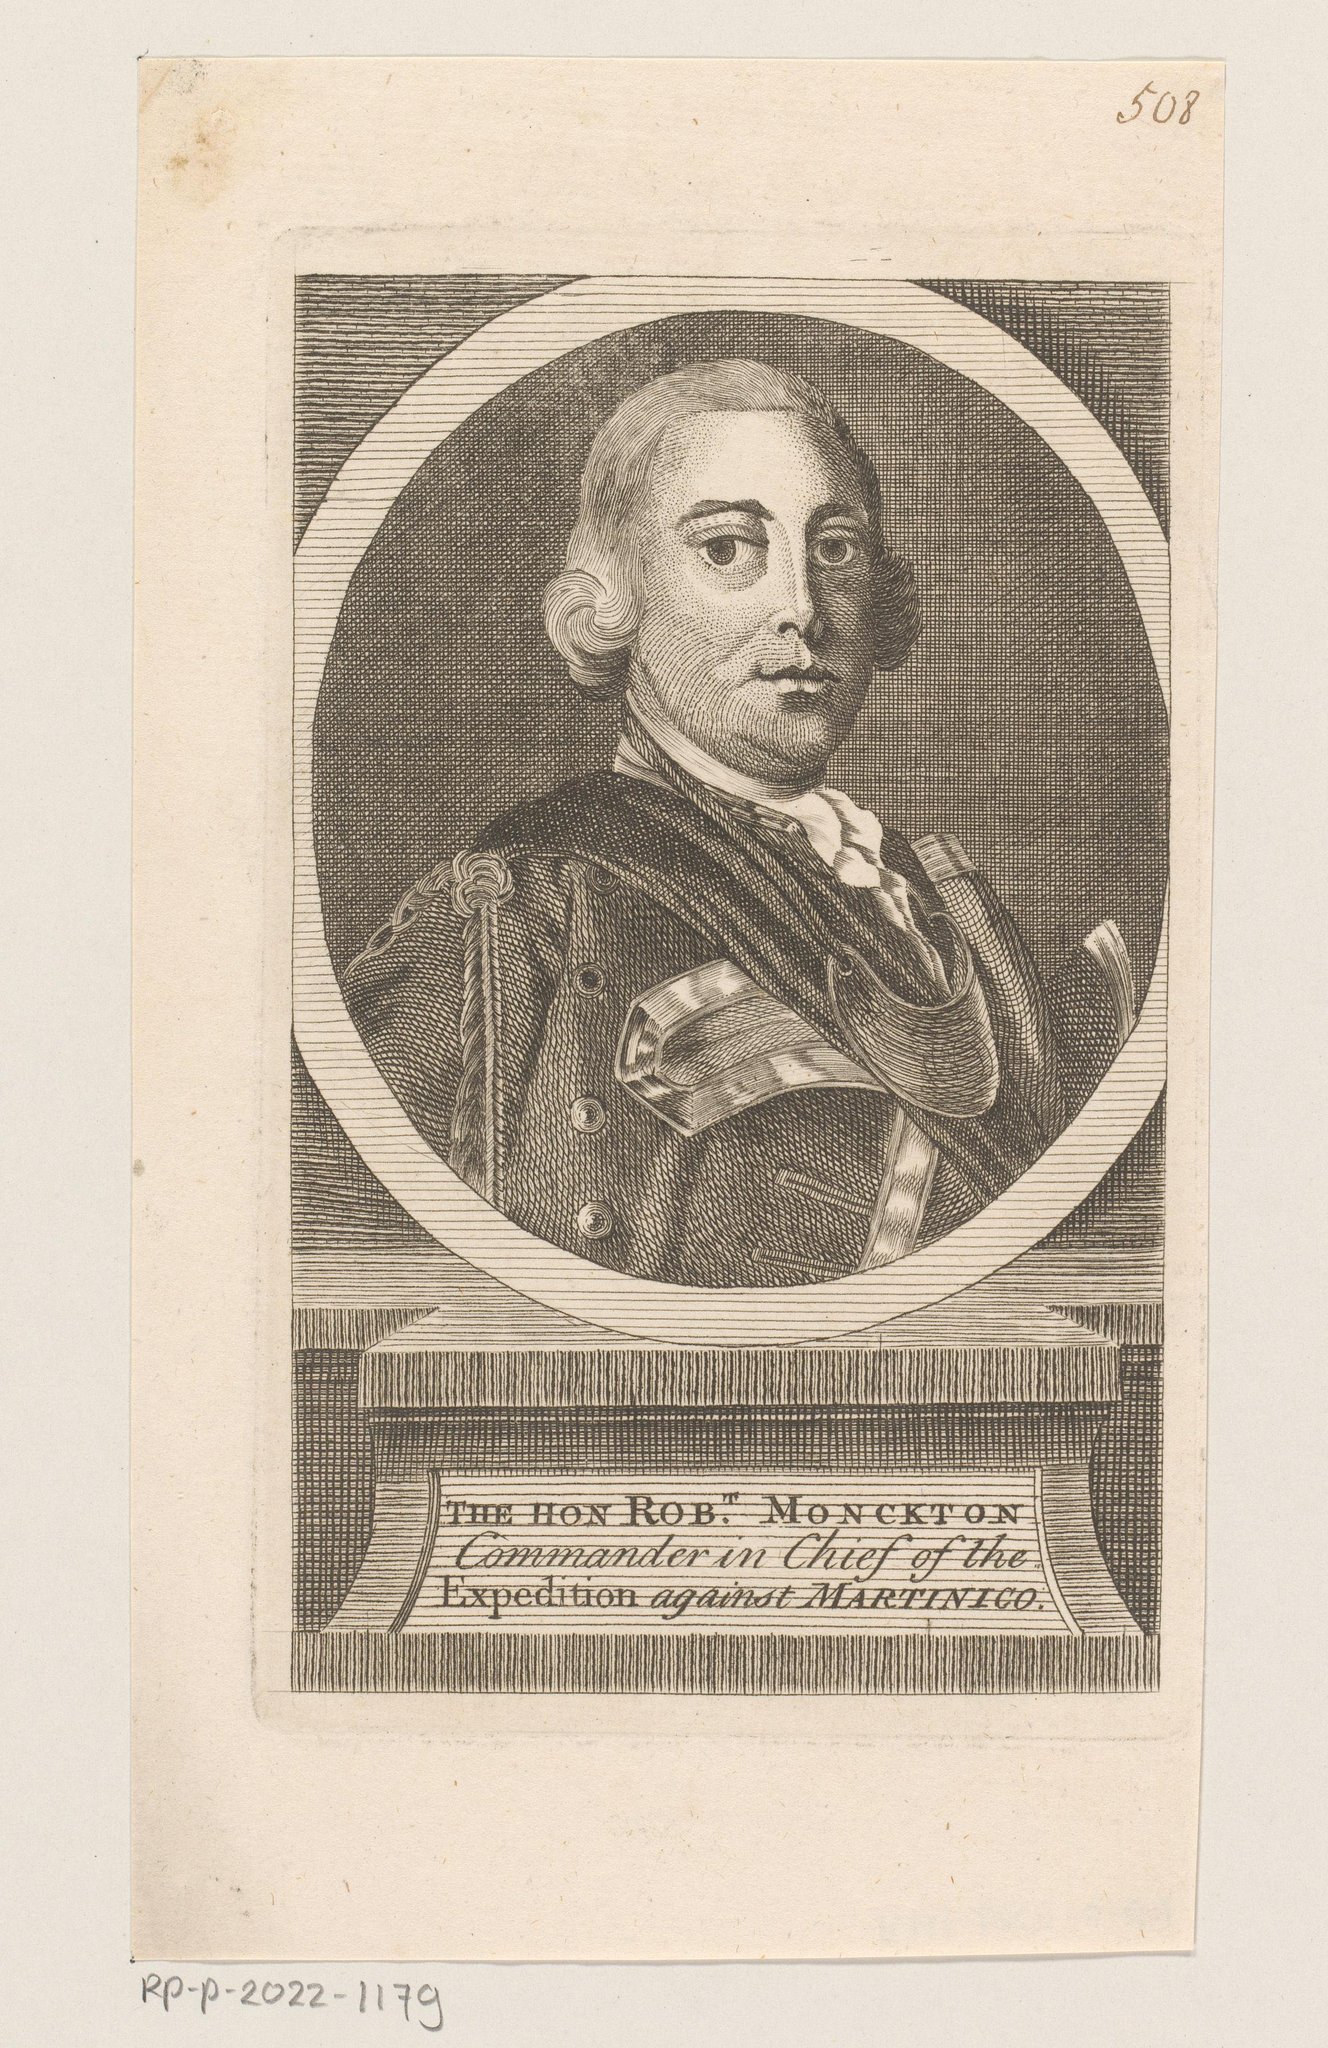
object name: print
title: The Hon Rob.t Monckton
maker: Anonymous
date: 1762-1850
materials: paper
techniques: engraving, etching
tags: robert monckton, commander-in-chief, general, marshal, historical persons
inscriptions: number